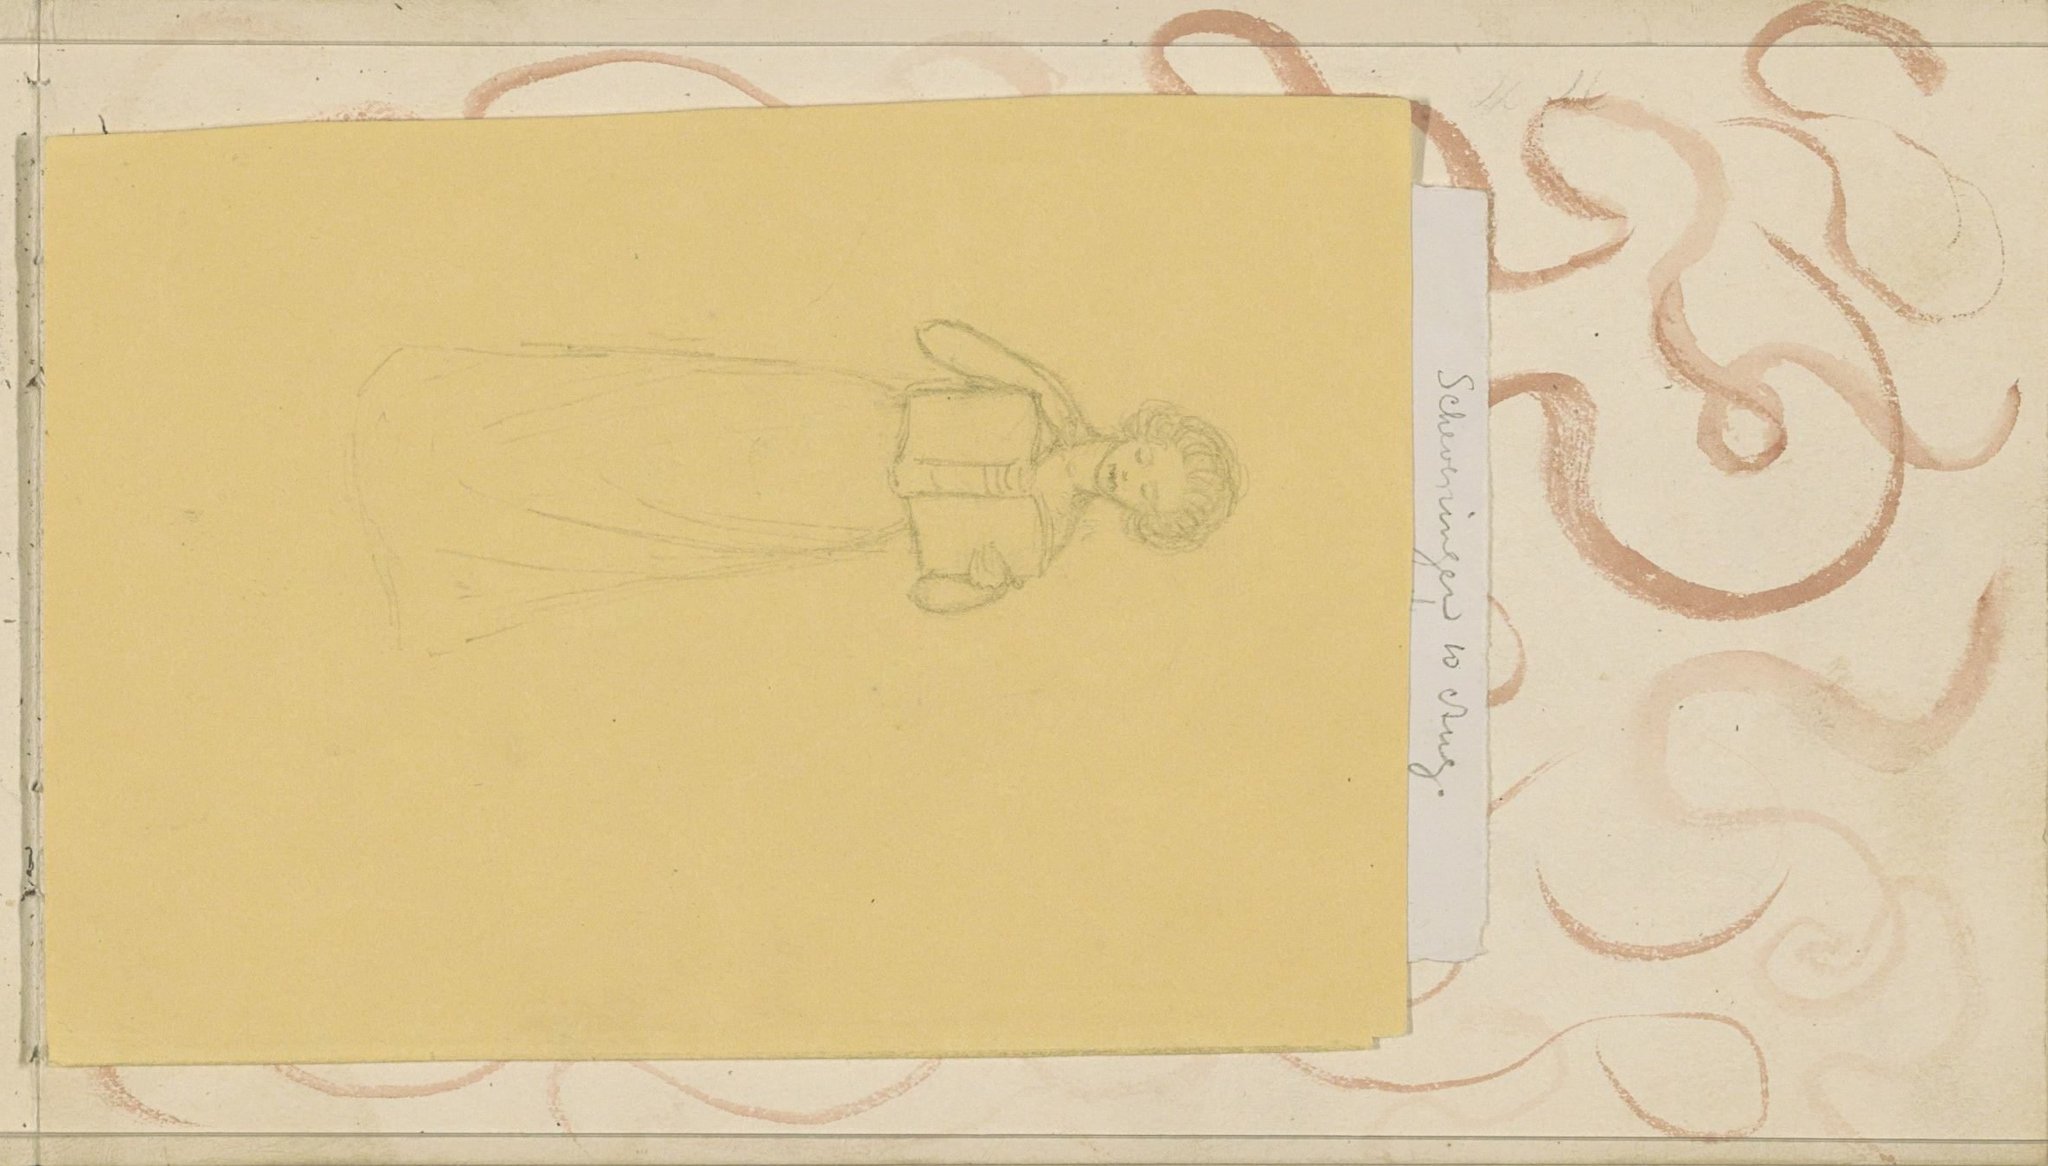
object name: sketchbook leaf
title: Staande vrouw met een boek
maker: julie de graag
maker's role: draughtsman, print maker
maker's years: 1877-1924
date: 1892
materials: paper, pencil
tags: standing figure, adult woman, book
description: Recto-zijde van een losse schets tussen pagina 1 en 2 uit een schetsboek met 22 bladen.